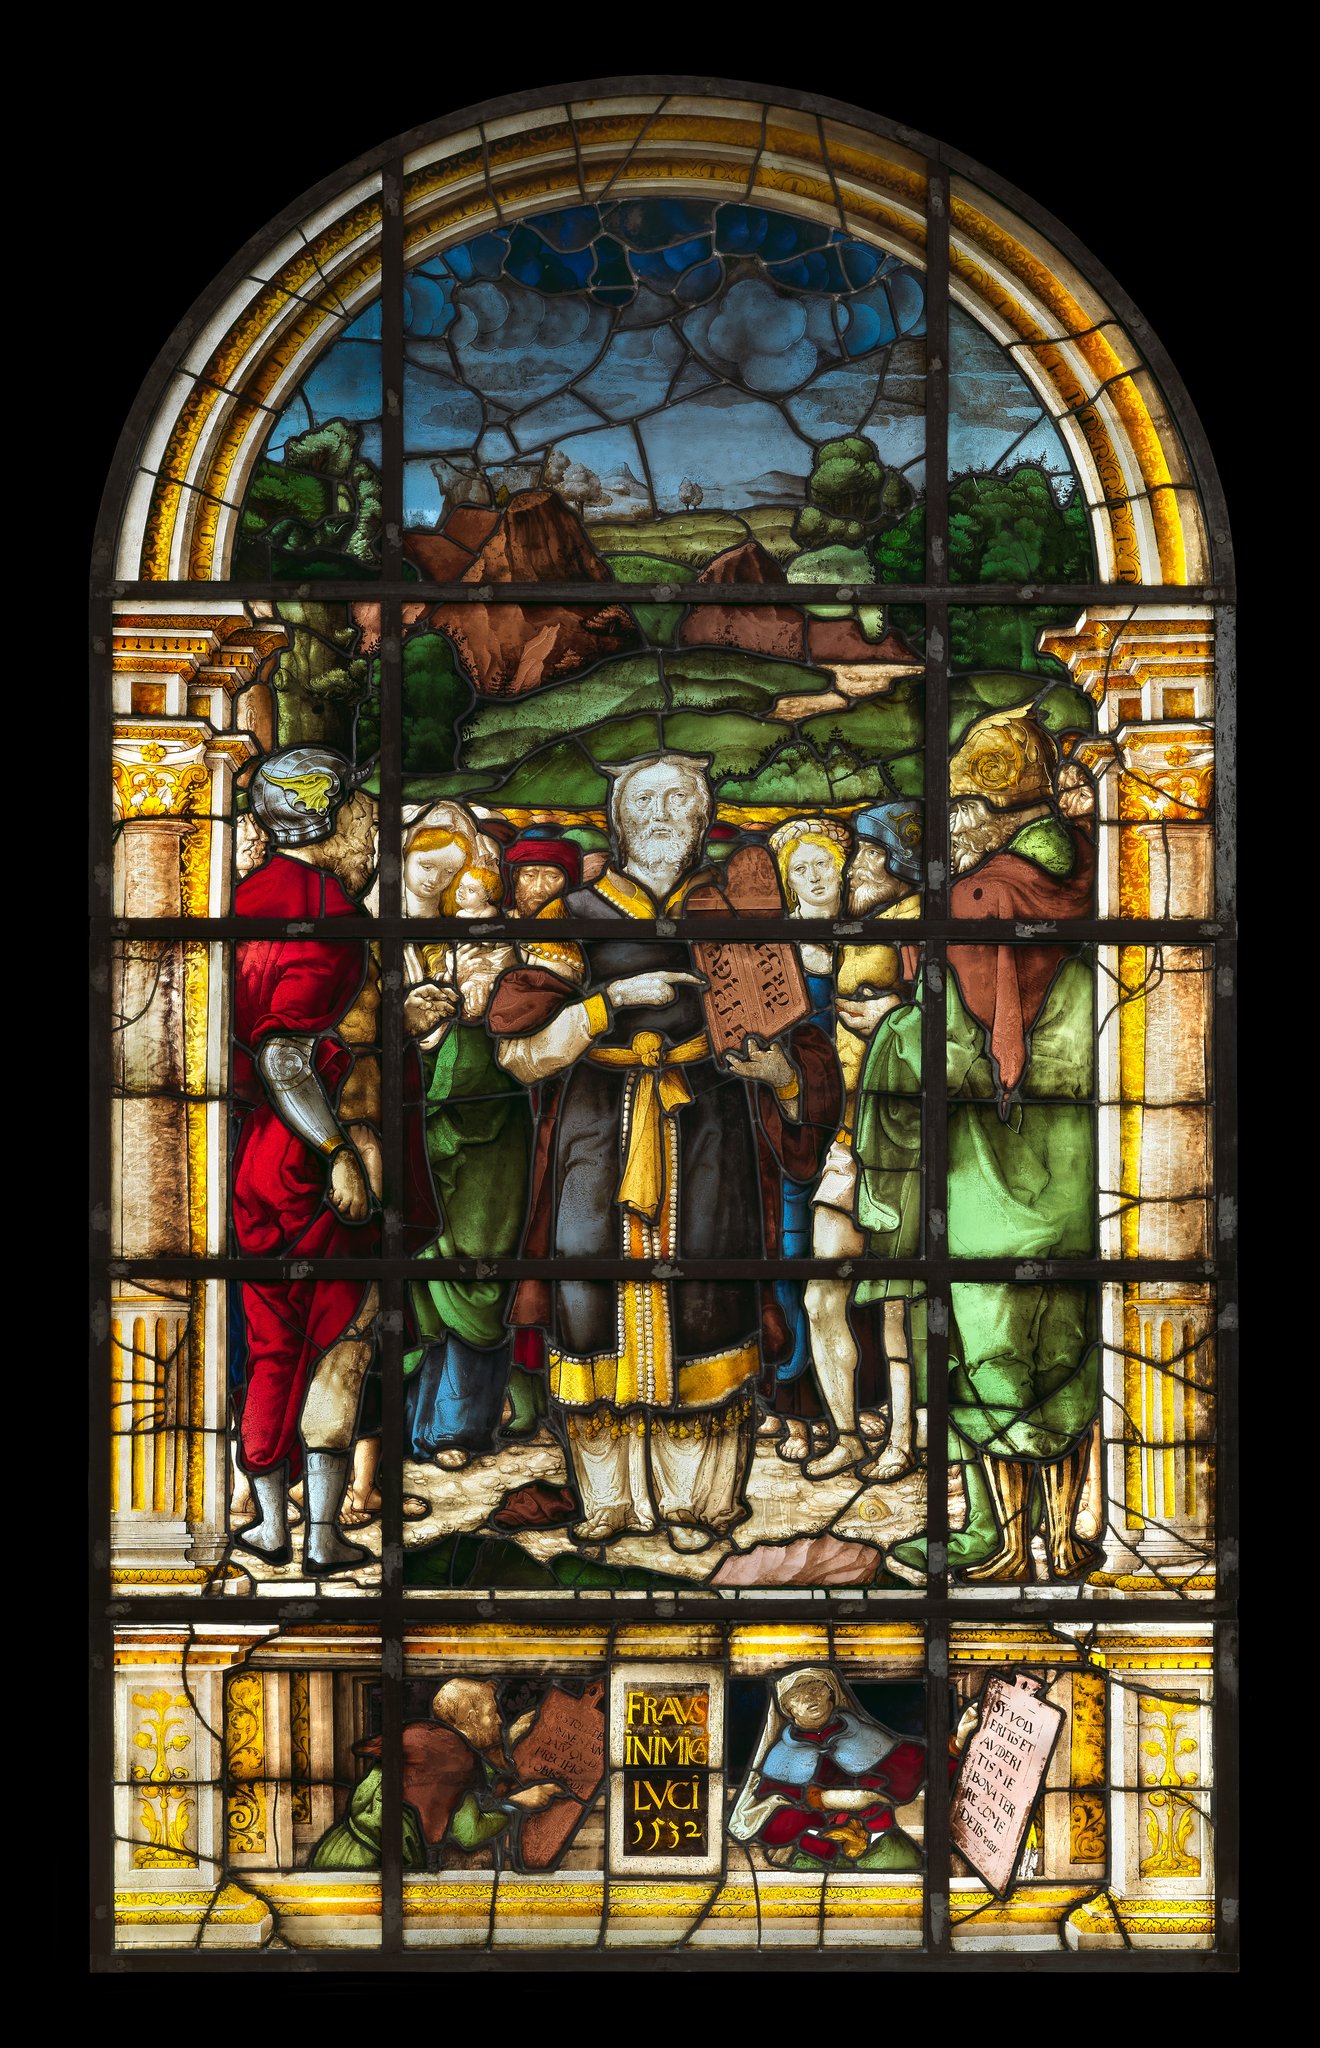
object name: window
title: Moses presenting the tablets of law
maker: valentin bousch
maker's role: artist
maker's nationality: french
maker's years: 1514-1541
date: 1532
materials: glass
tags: men,women,moses